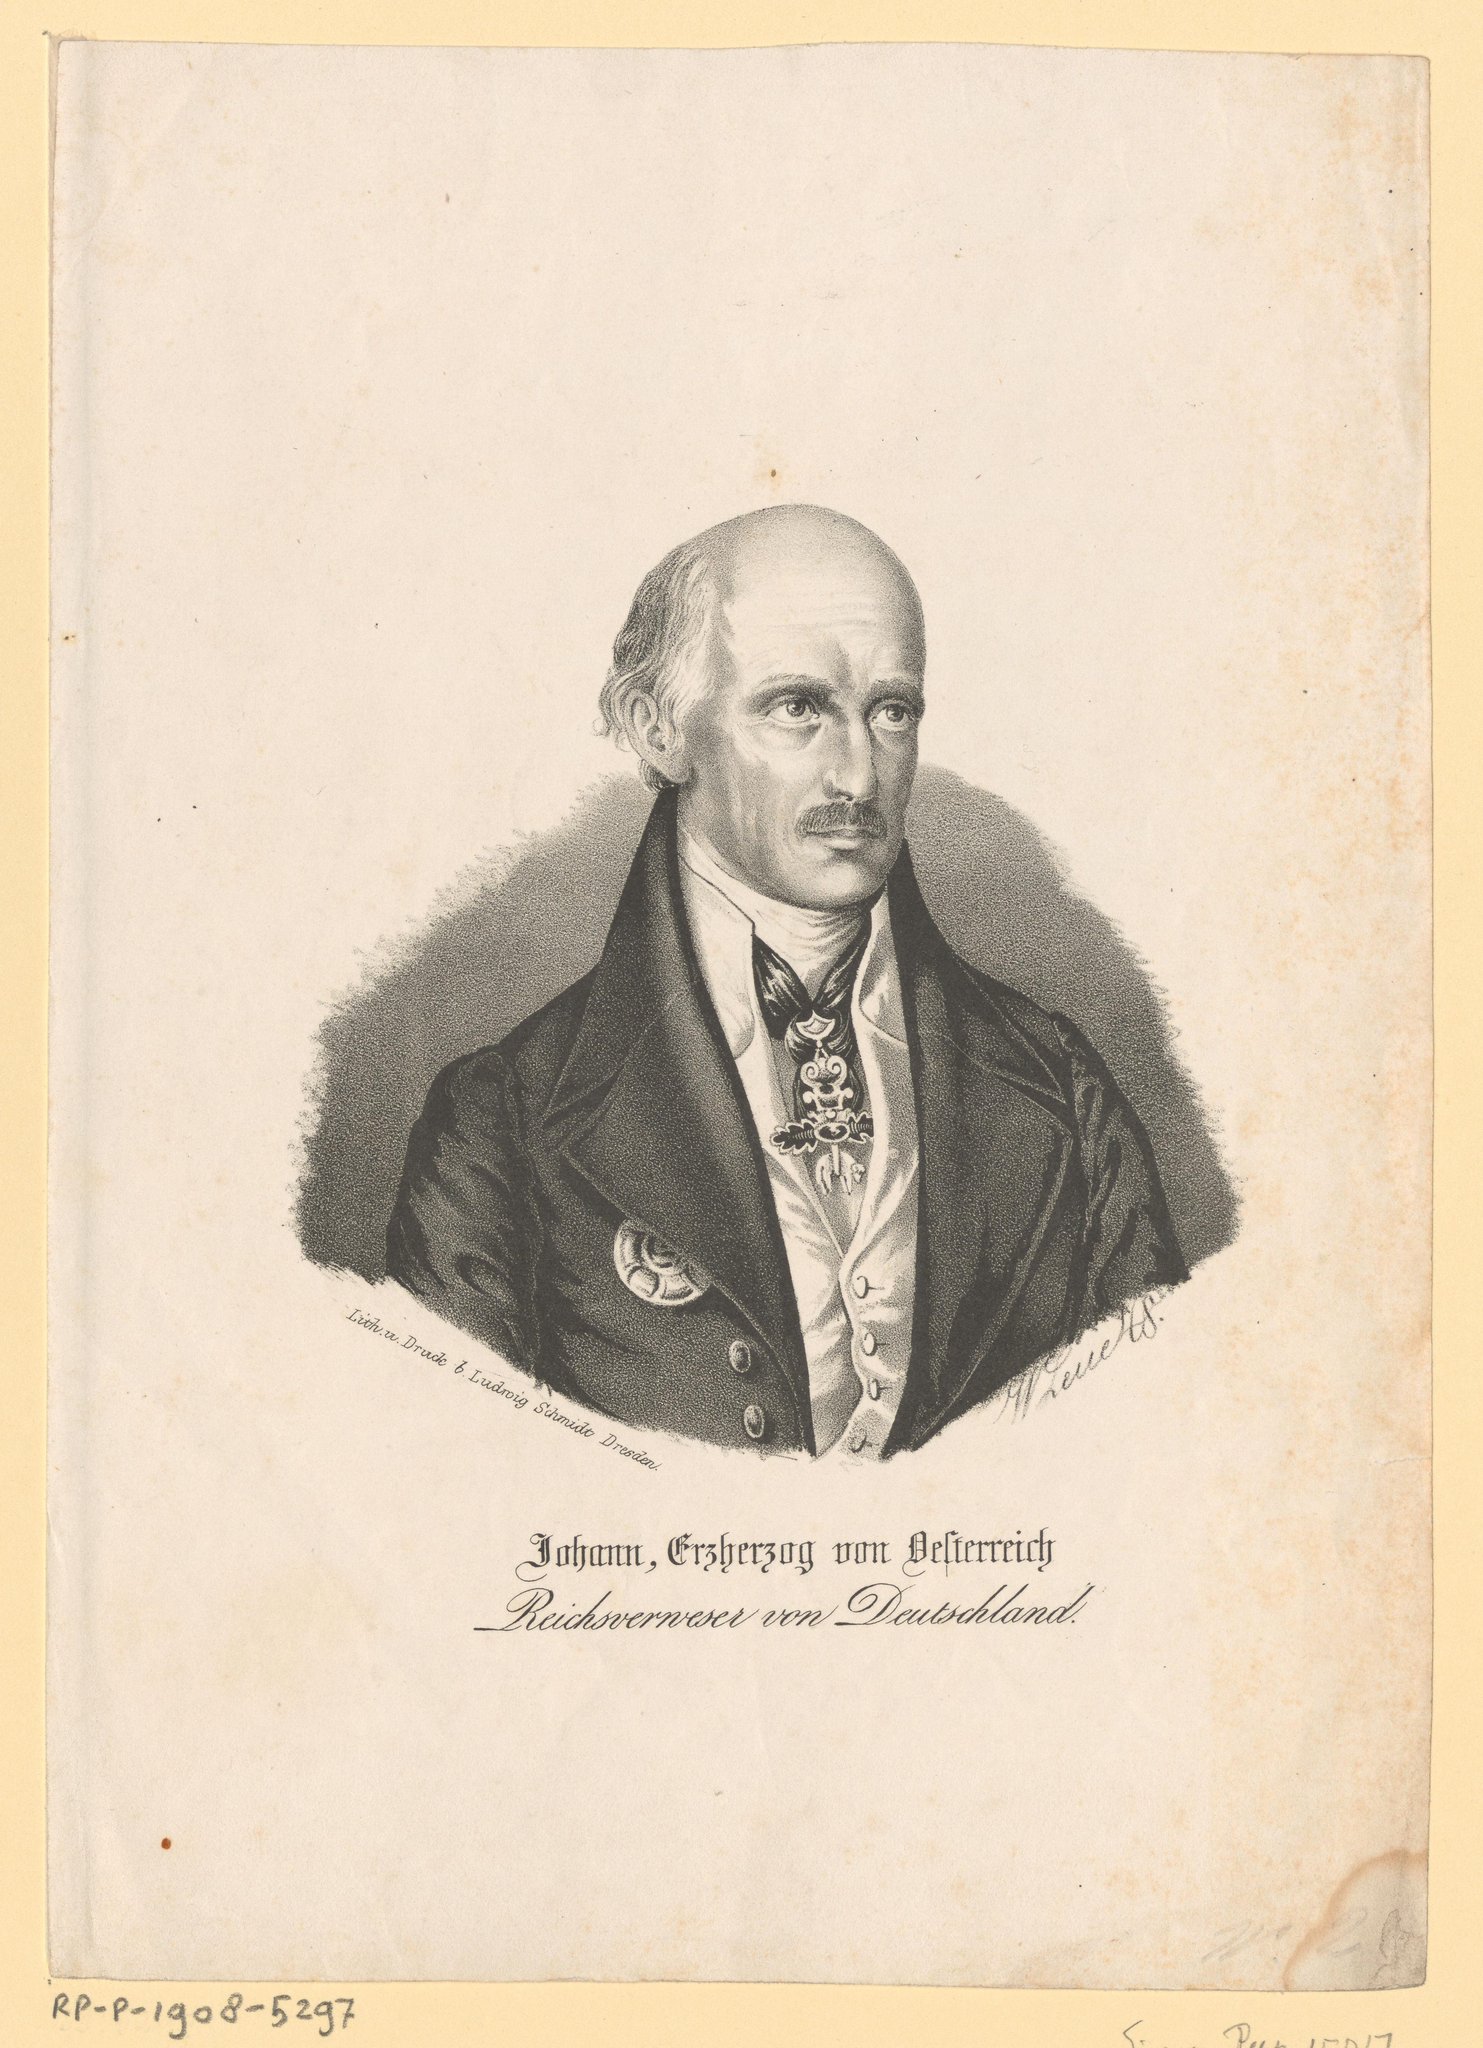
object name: print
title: Portret van Johan van Oostenrijk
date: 1800-1849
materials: paper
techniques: lithograph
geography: dresden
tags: commander-in-chief, general, marshal, historical persons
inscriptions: collector's mark: Lugt 2228, monogram: ‘WLeue[ts]’